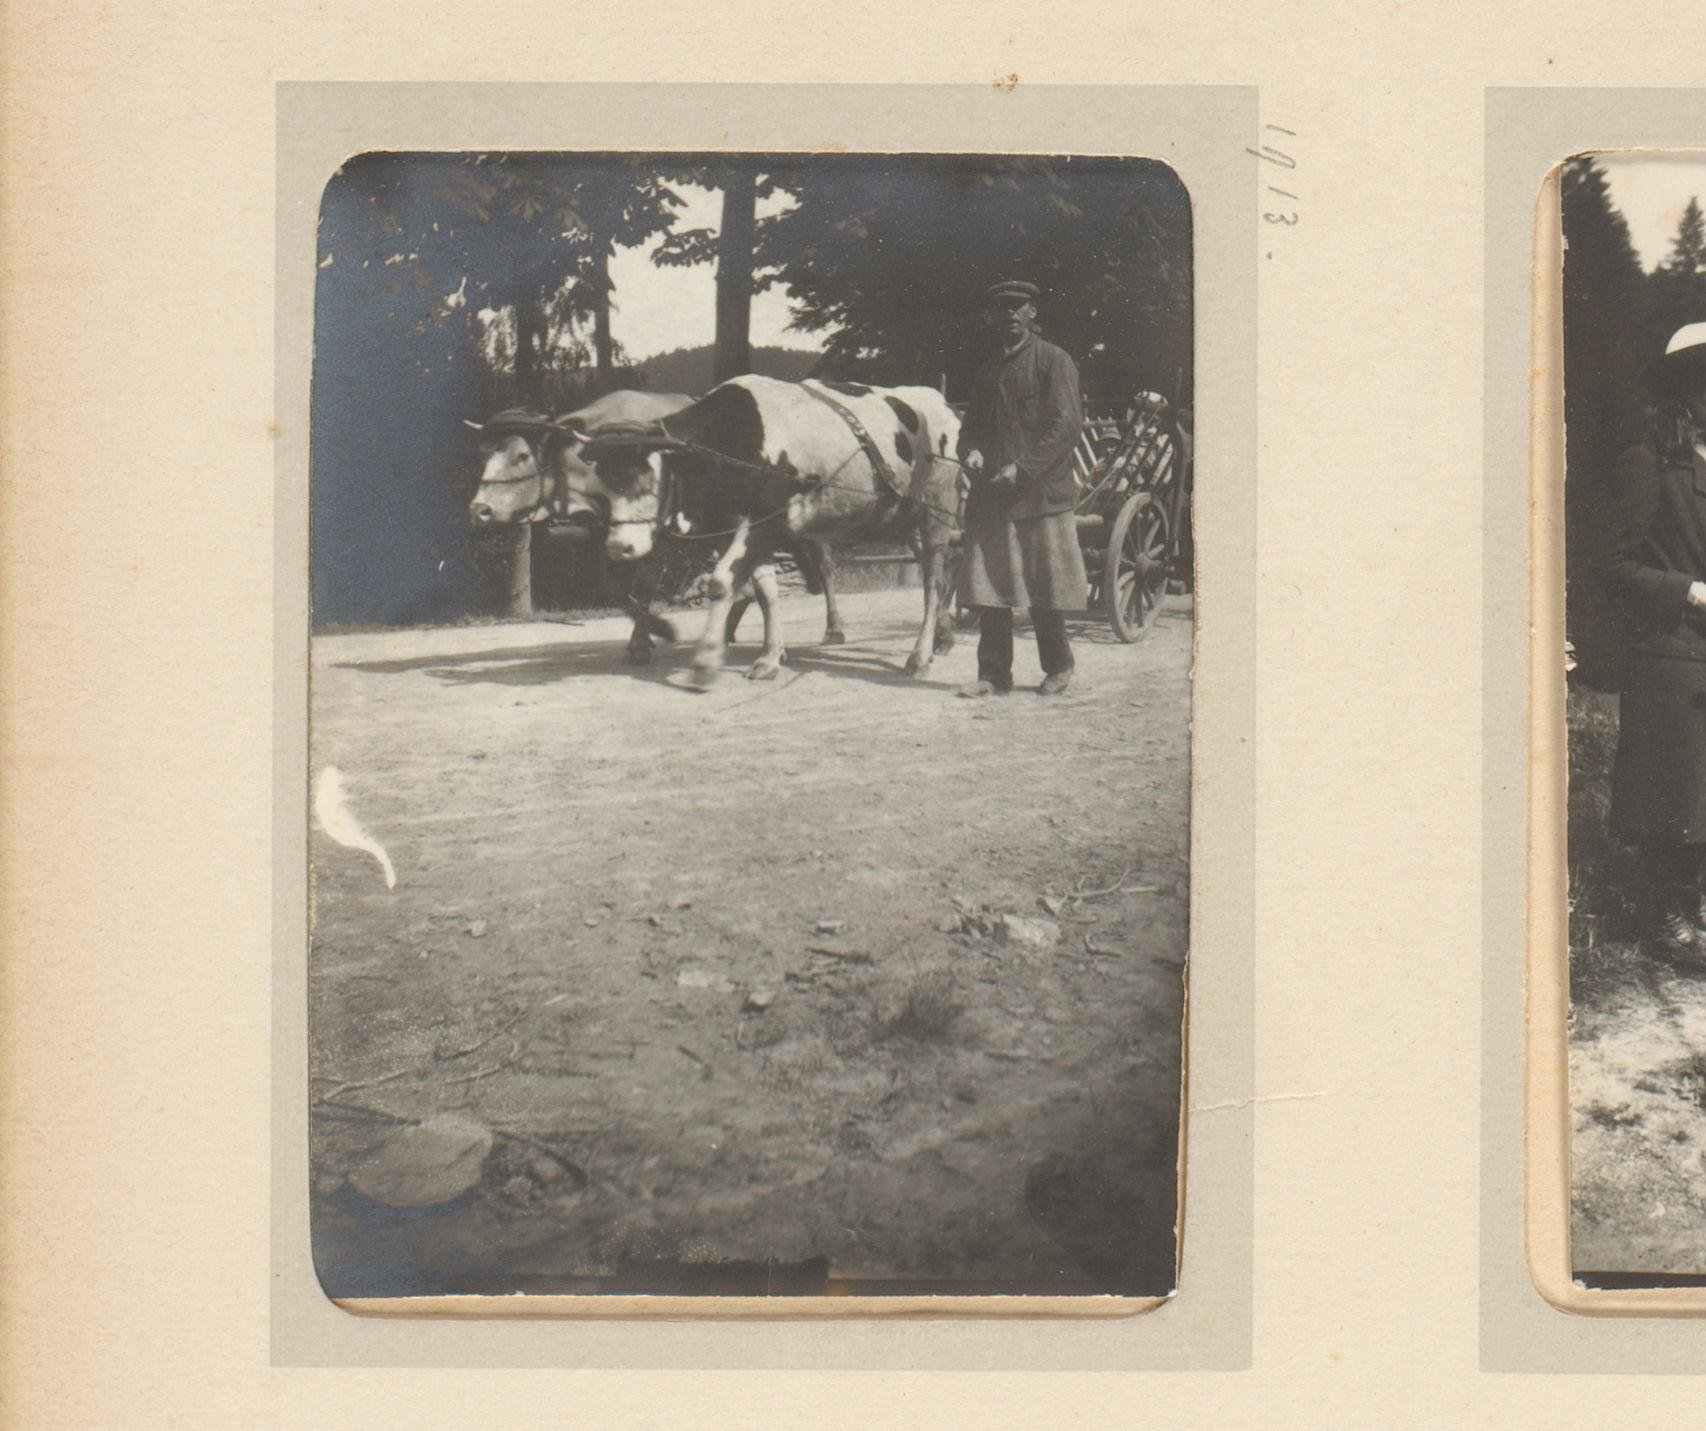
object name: album leaf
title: Boer met kar, getrokken door twee ossen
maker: liesbeth overhoff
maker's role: fotograaf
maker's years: 1895-1969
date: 1913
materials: paper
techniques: gelatin silver print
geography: oberhof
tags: ox, agriculture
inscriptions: inscription: ‘1913.’